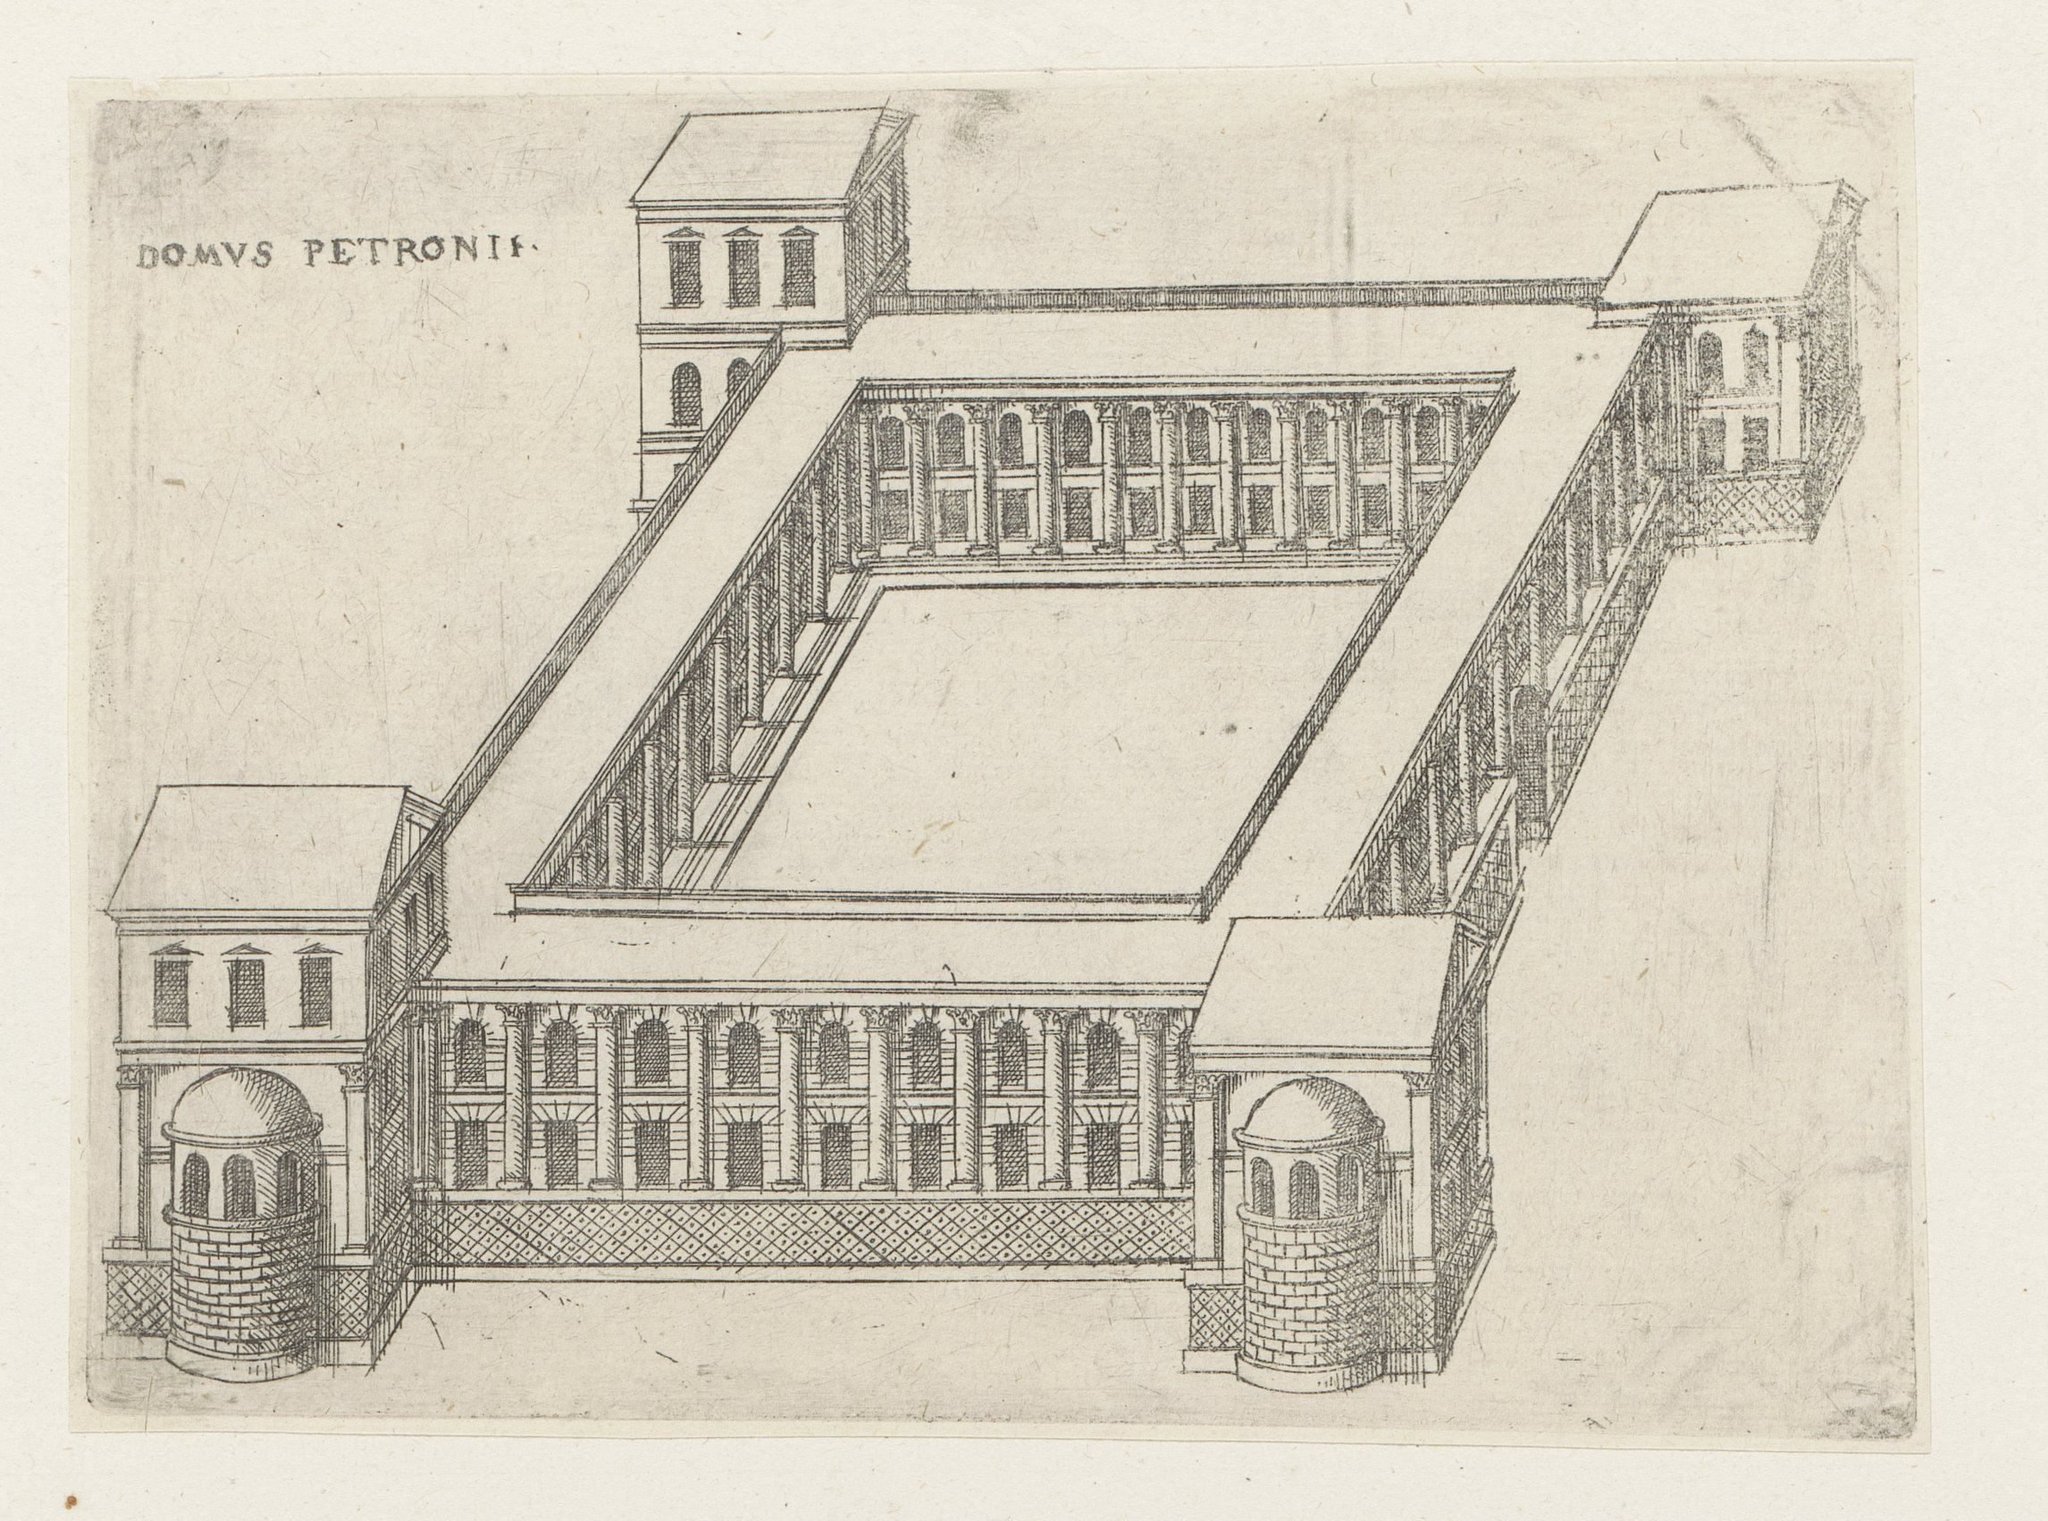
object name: print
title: De Domus Petronius Maximus te Rome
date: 1584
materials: paper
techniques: etching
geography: paris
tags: representation of real building (either existing or having existed), village square, place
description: Deze prent maakt deel uit van een serie van 98 prenten gedrukt op 48 bladen. De bladen zijn verknipt en een selectie van de losse prenten is in dit album geplakt.